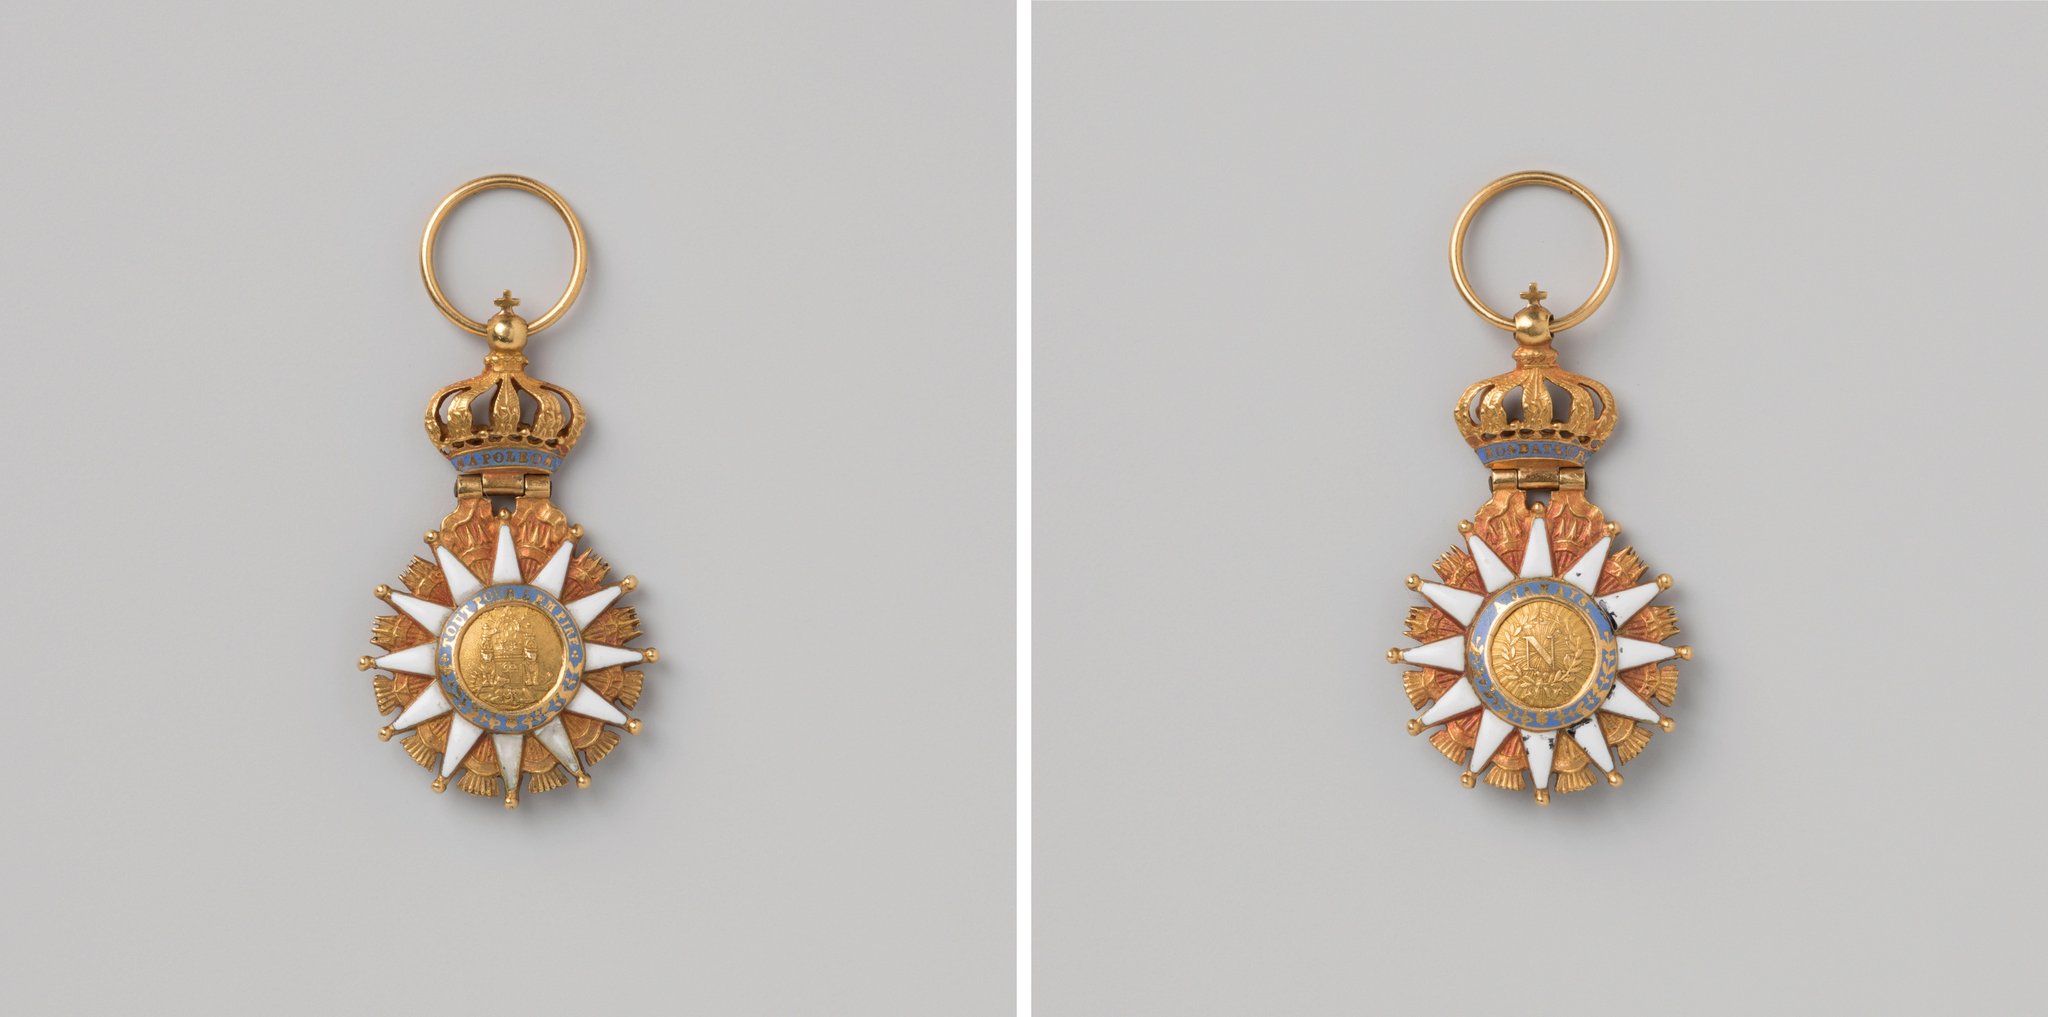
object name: insignia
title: Ordeteken van de Orde van de Reünie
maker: Anonymous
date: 1810-1815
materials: gold, metal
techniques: forging, striking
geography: france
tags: napoleon i (emperor of the french)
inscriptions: edge inscription: ‘TOUT POUR L'EMPIRE’, inscription: ‘A JAMAIS’, inscription: ‘NAPOLEON / FONDATEUR’, inscription: ‘M:N’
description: Decorations and medals, 1806-1813. King Louis Napoleon instituted two national orders: the Order of Merit, with the motto 'do well and do not look back', and the Order of the Union, with the motto 'luctor et emergo'. A year later the two orders were merged to form the Royal Order of Holland, renamed the Royal Order of the Union after 1808. Instead of the king's head, the medal showed a bundle of arrows. When the Netherlands was annexed by France in 1810, Emperor Napoleon introduced the Order of Reunion to replace the Order of the Union. These decorations were originally awarded to I.J.A. Gogel, who served for many years as minister of finance.